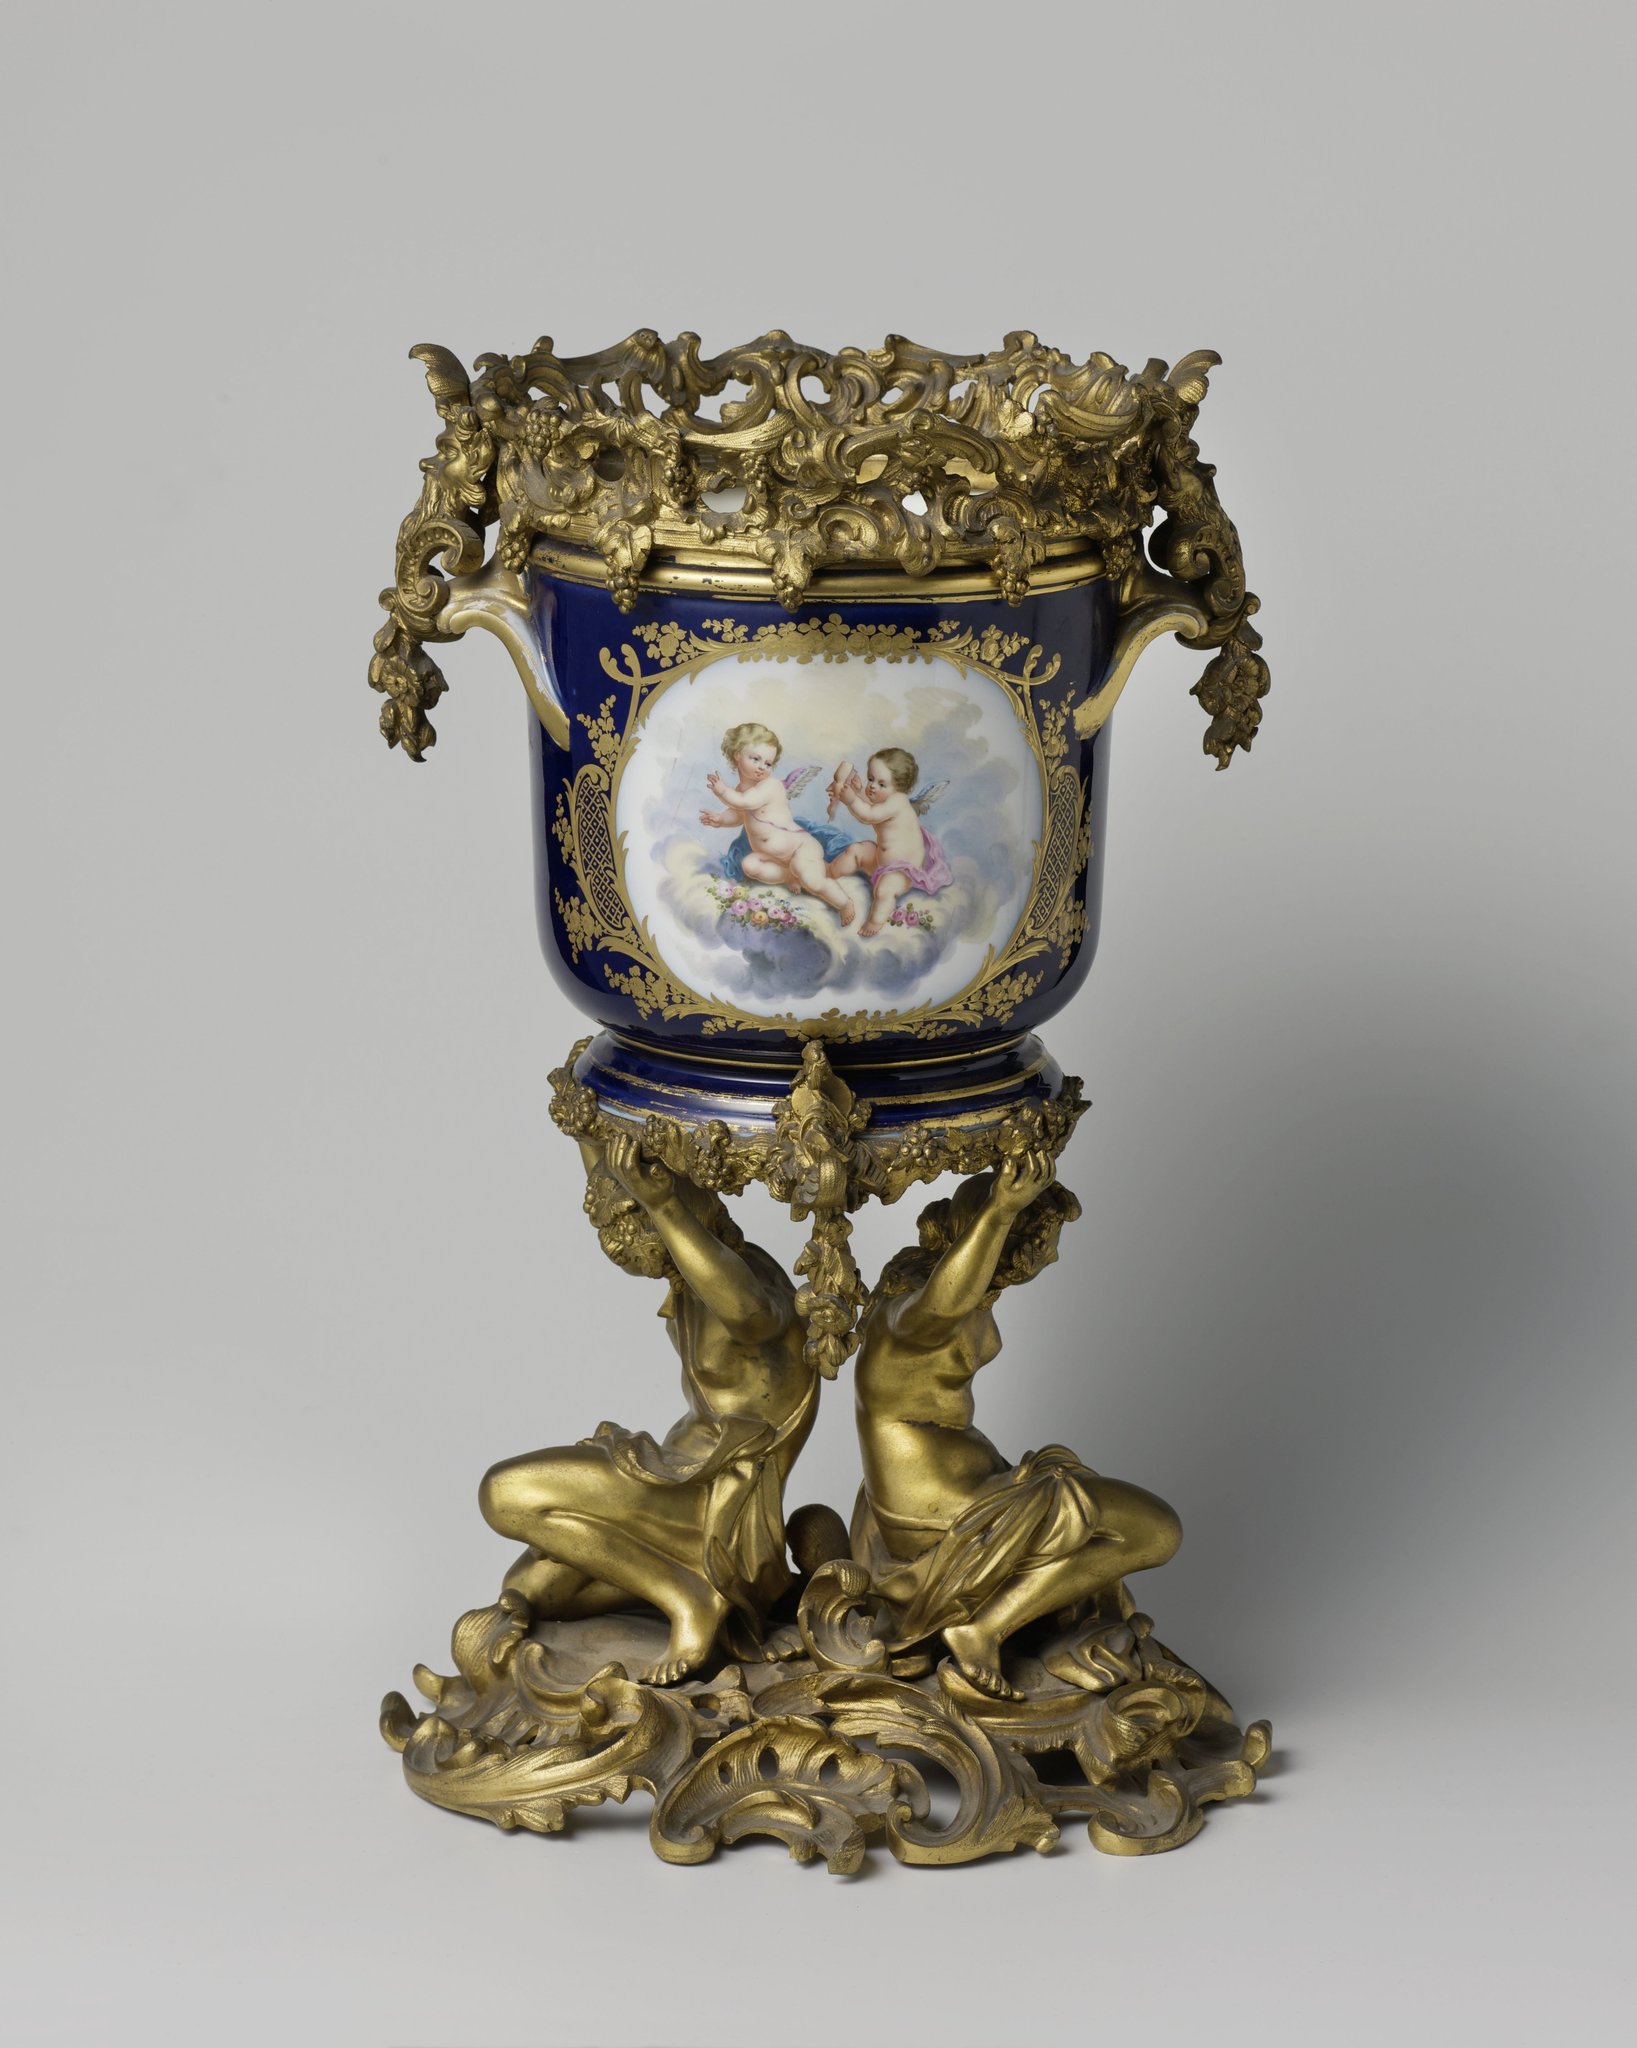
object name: jardinière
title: Jardinière with putti and floral scrolls, with a metal mount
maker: Anonymous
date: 1850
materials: glaze, gold, metal, paint, porcelain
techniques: firing, forming, gilding, turning, vitrification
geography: france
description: Jardinière van porselein, beschilderd op het glazuur in emailkleuren en goud. De buitenwand is bedekt met blauw met daarin uitgespaard tweemaal een groot, rijk gedecoreerd vak met twee putti op een wolk of bloemtakken. De pot is gevat in een uitgebreid verguld metalen montuur. De voet is in de vorm van twee antieke figuren met een krans van druivenranken en knielend op bladranken, die de pot boven hun hoofd dragen. Ook de rand is gevat in een montuur met krulwerk, druivenranken en tweemaal een faun als handvat. Imitatie Sèvres.